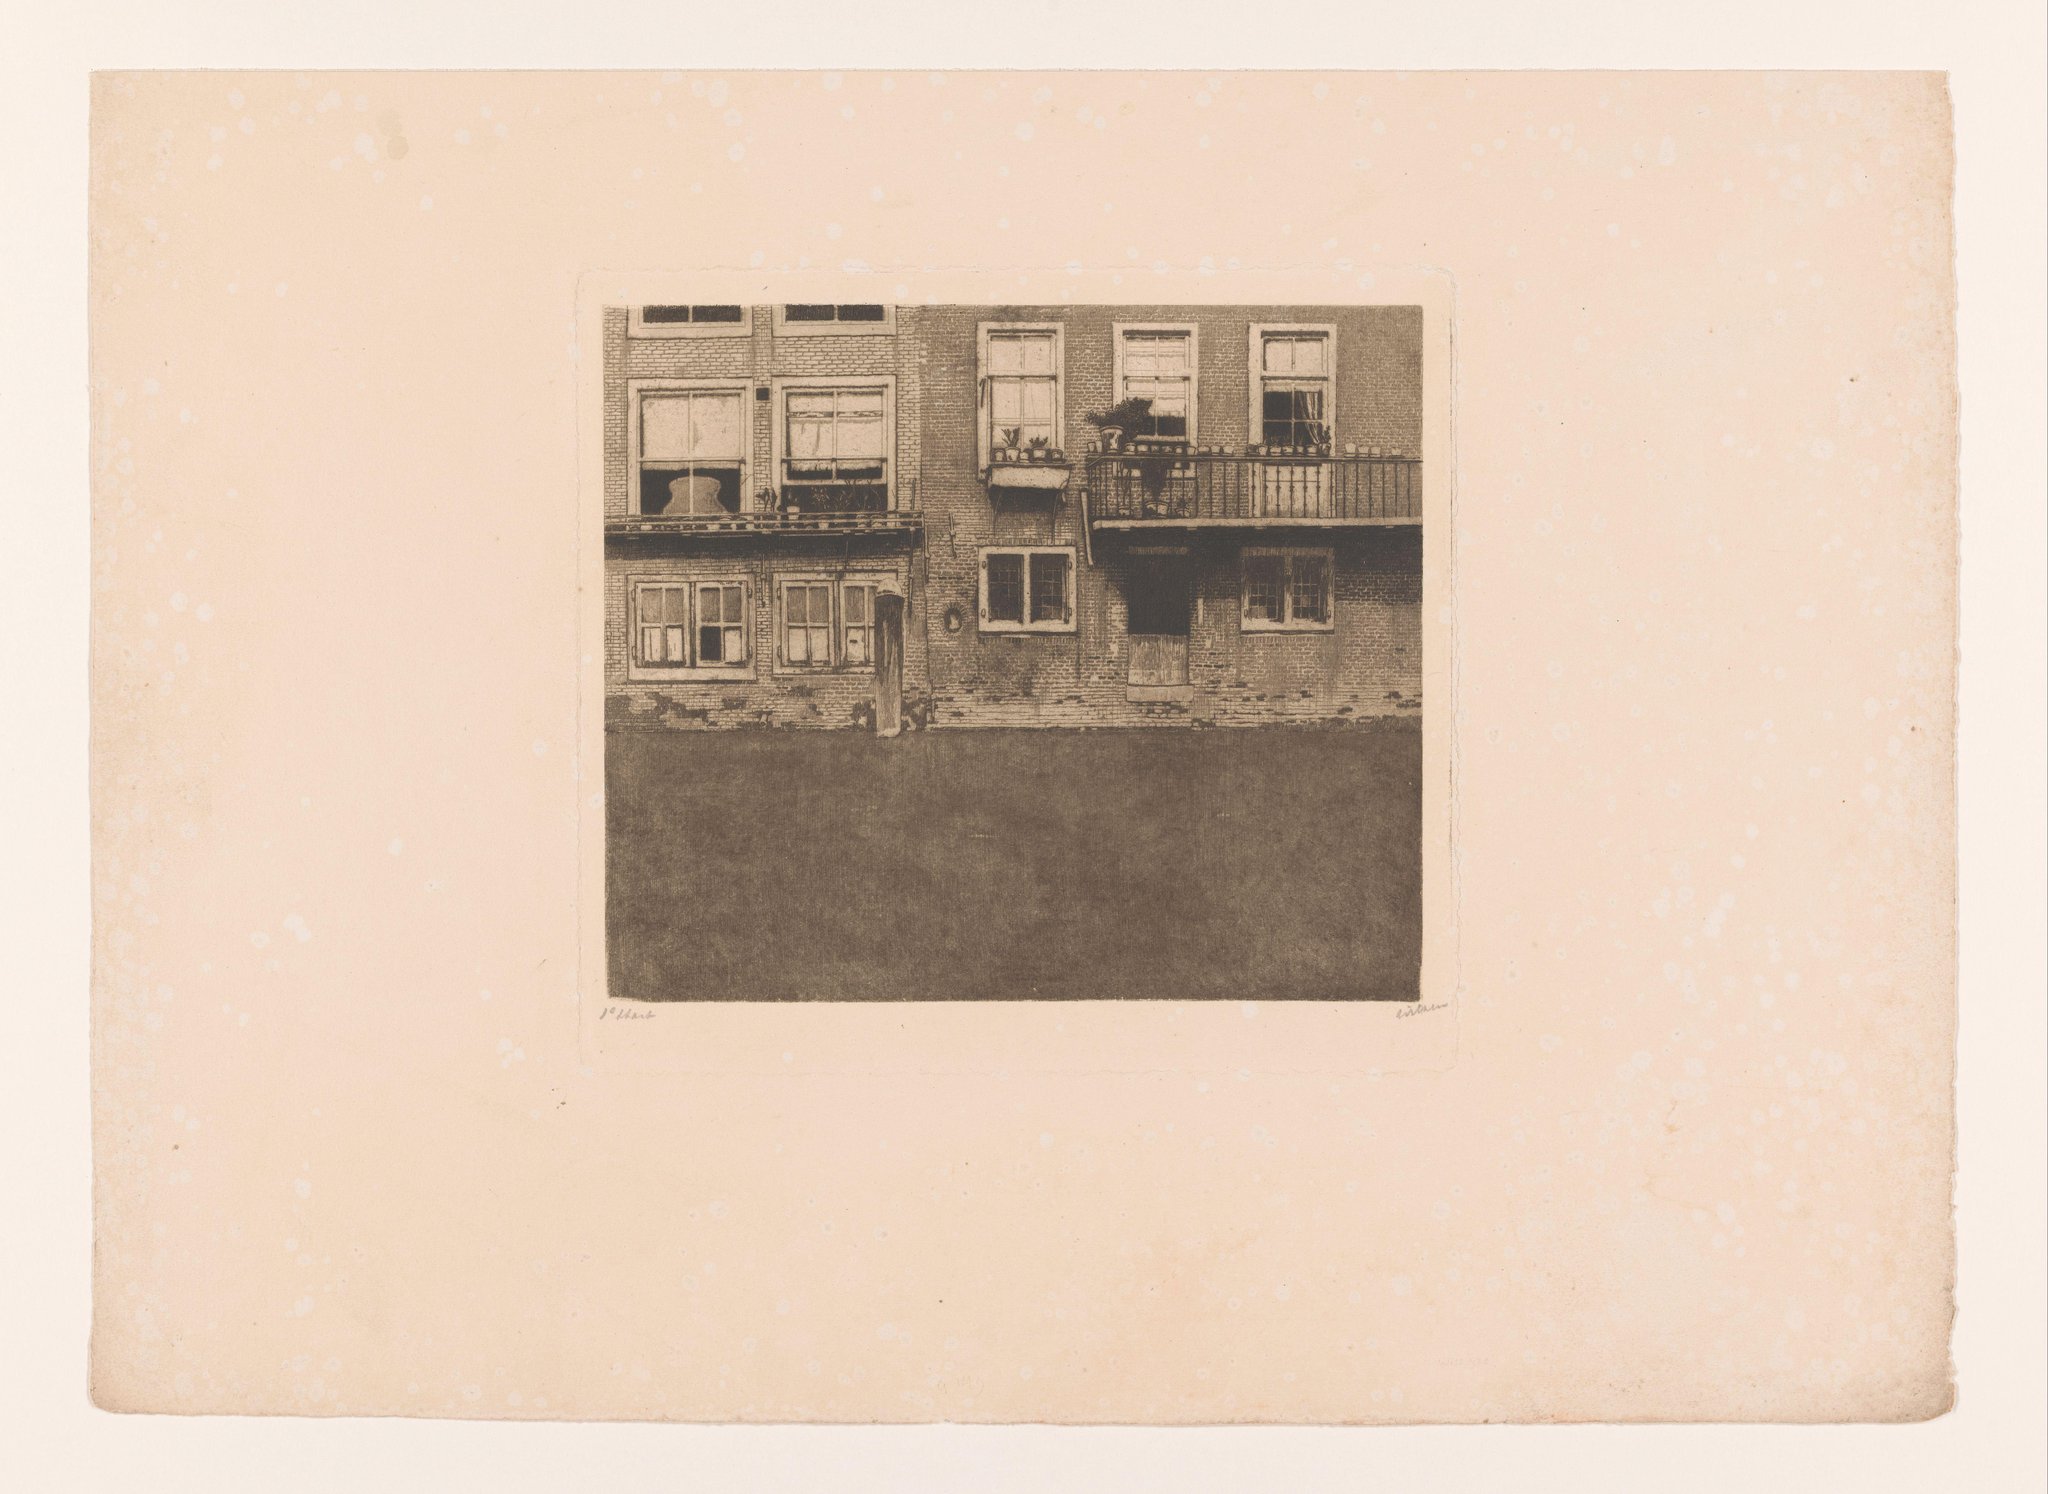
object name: print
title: Voorstraatshaven V, Dordrecht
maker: willem witsen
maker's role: draughtsman, painter, print maker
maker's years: 1860-1923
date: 1898-1900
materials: paper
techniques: aquatint, etching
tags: urban housing, canals, waters (in city)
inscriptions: annotation: ‘1e staat’